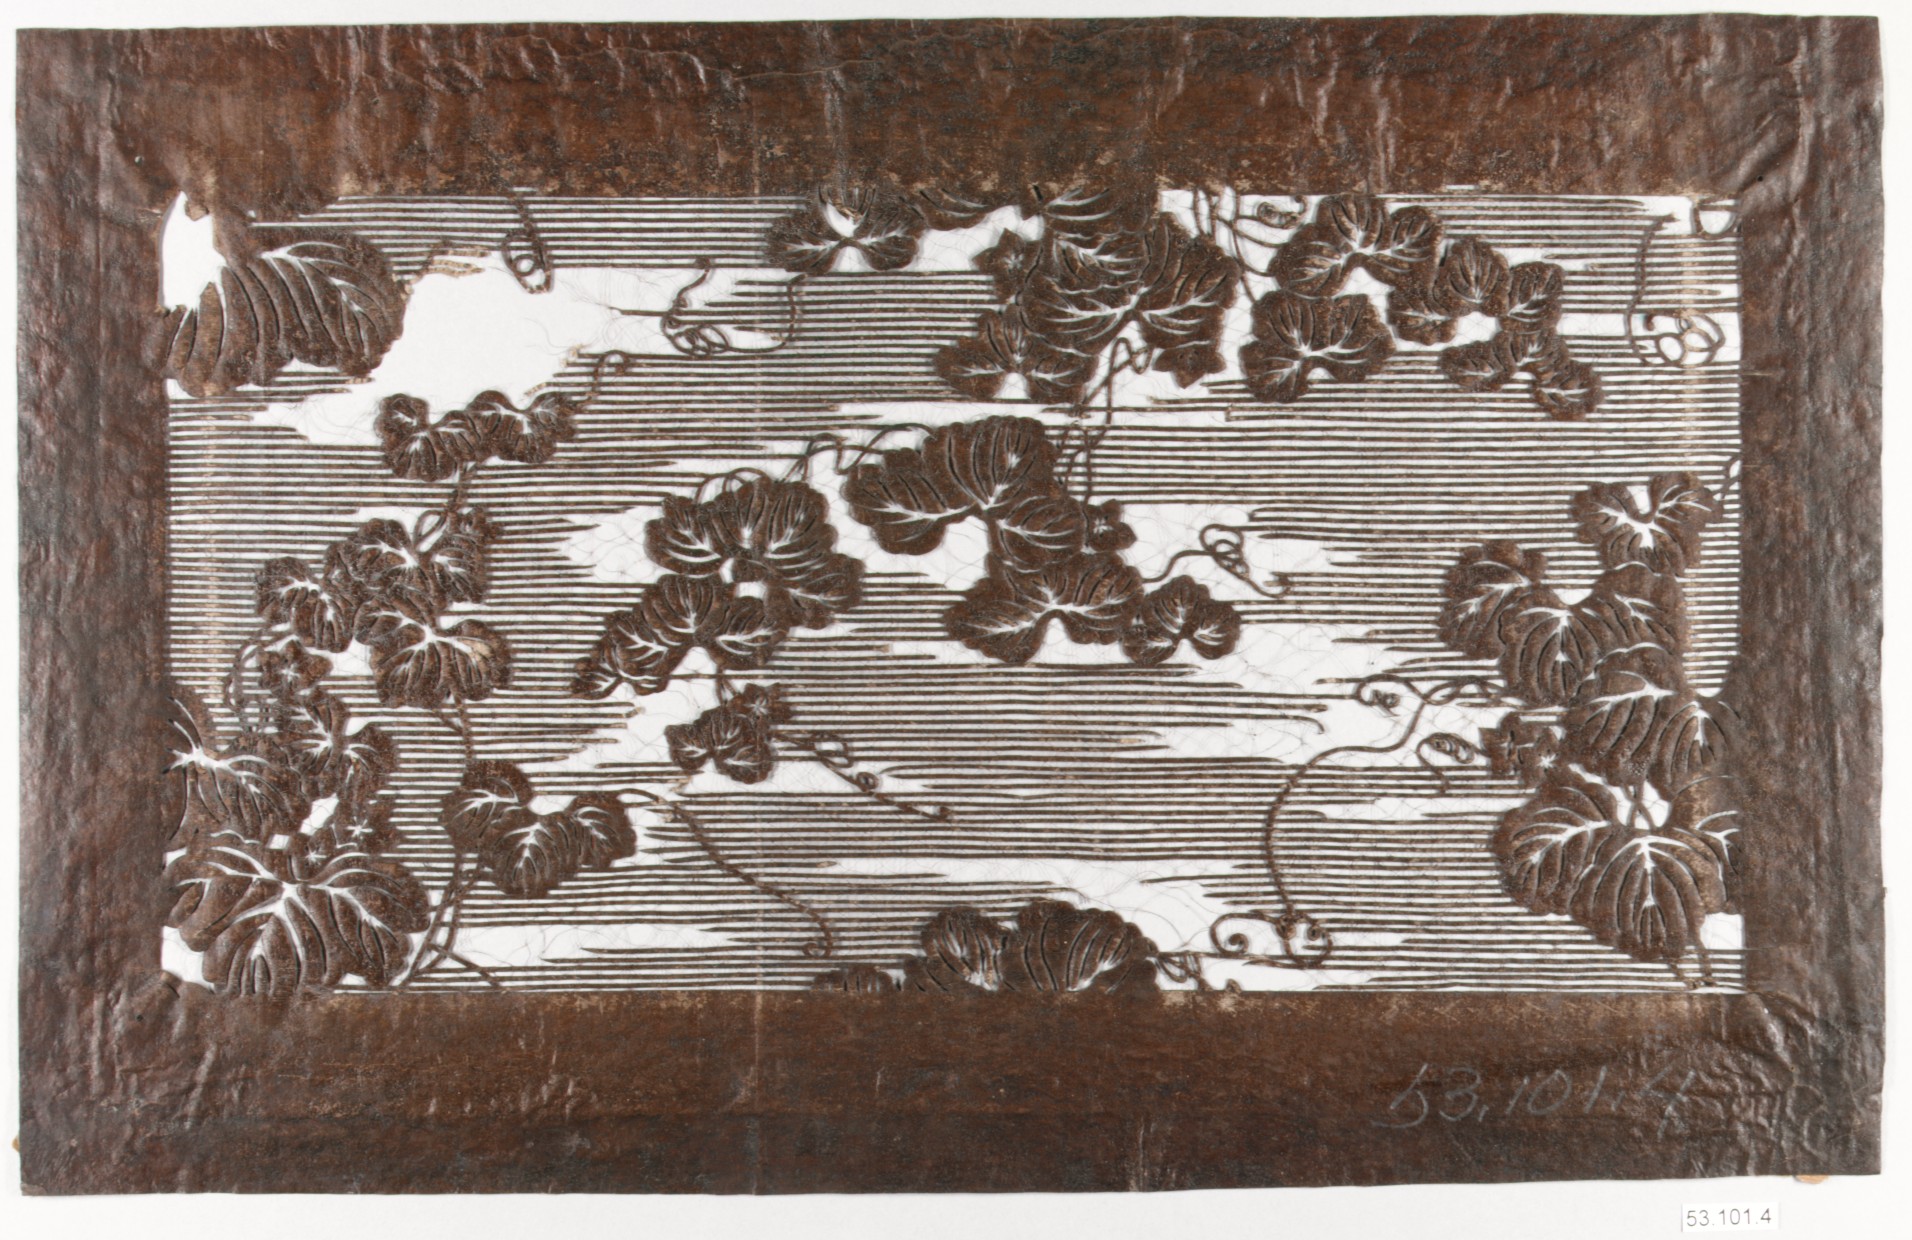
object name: stencil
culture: japanese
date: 1615-1868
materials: paper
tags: leaves